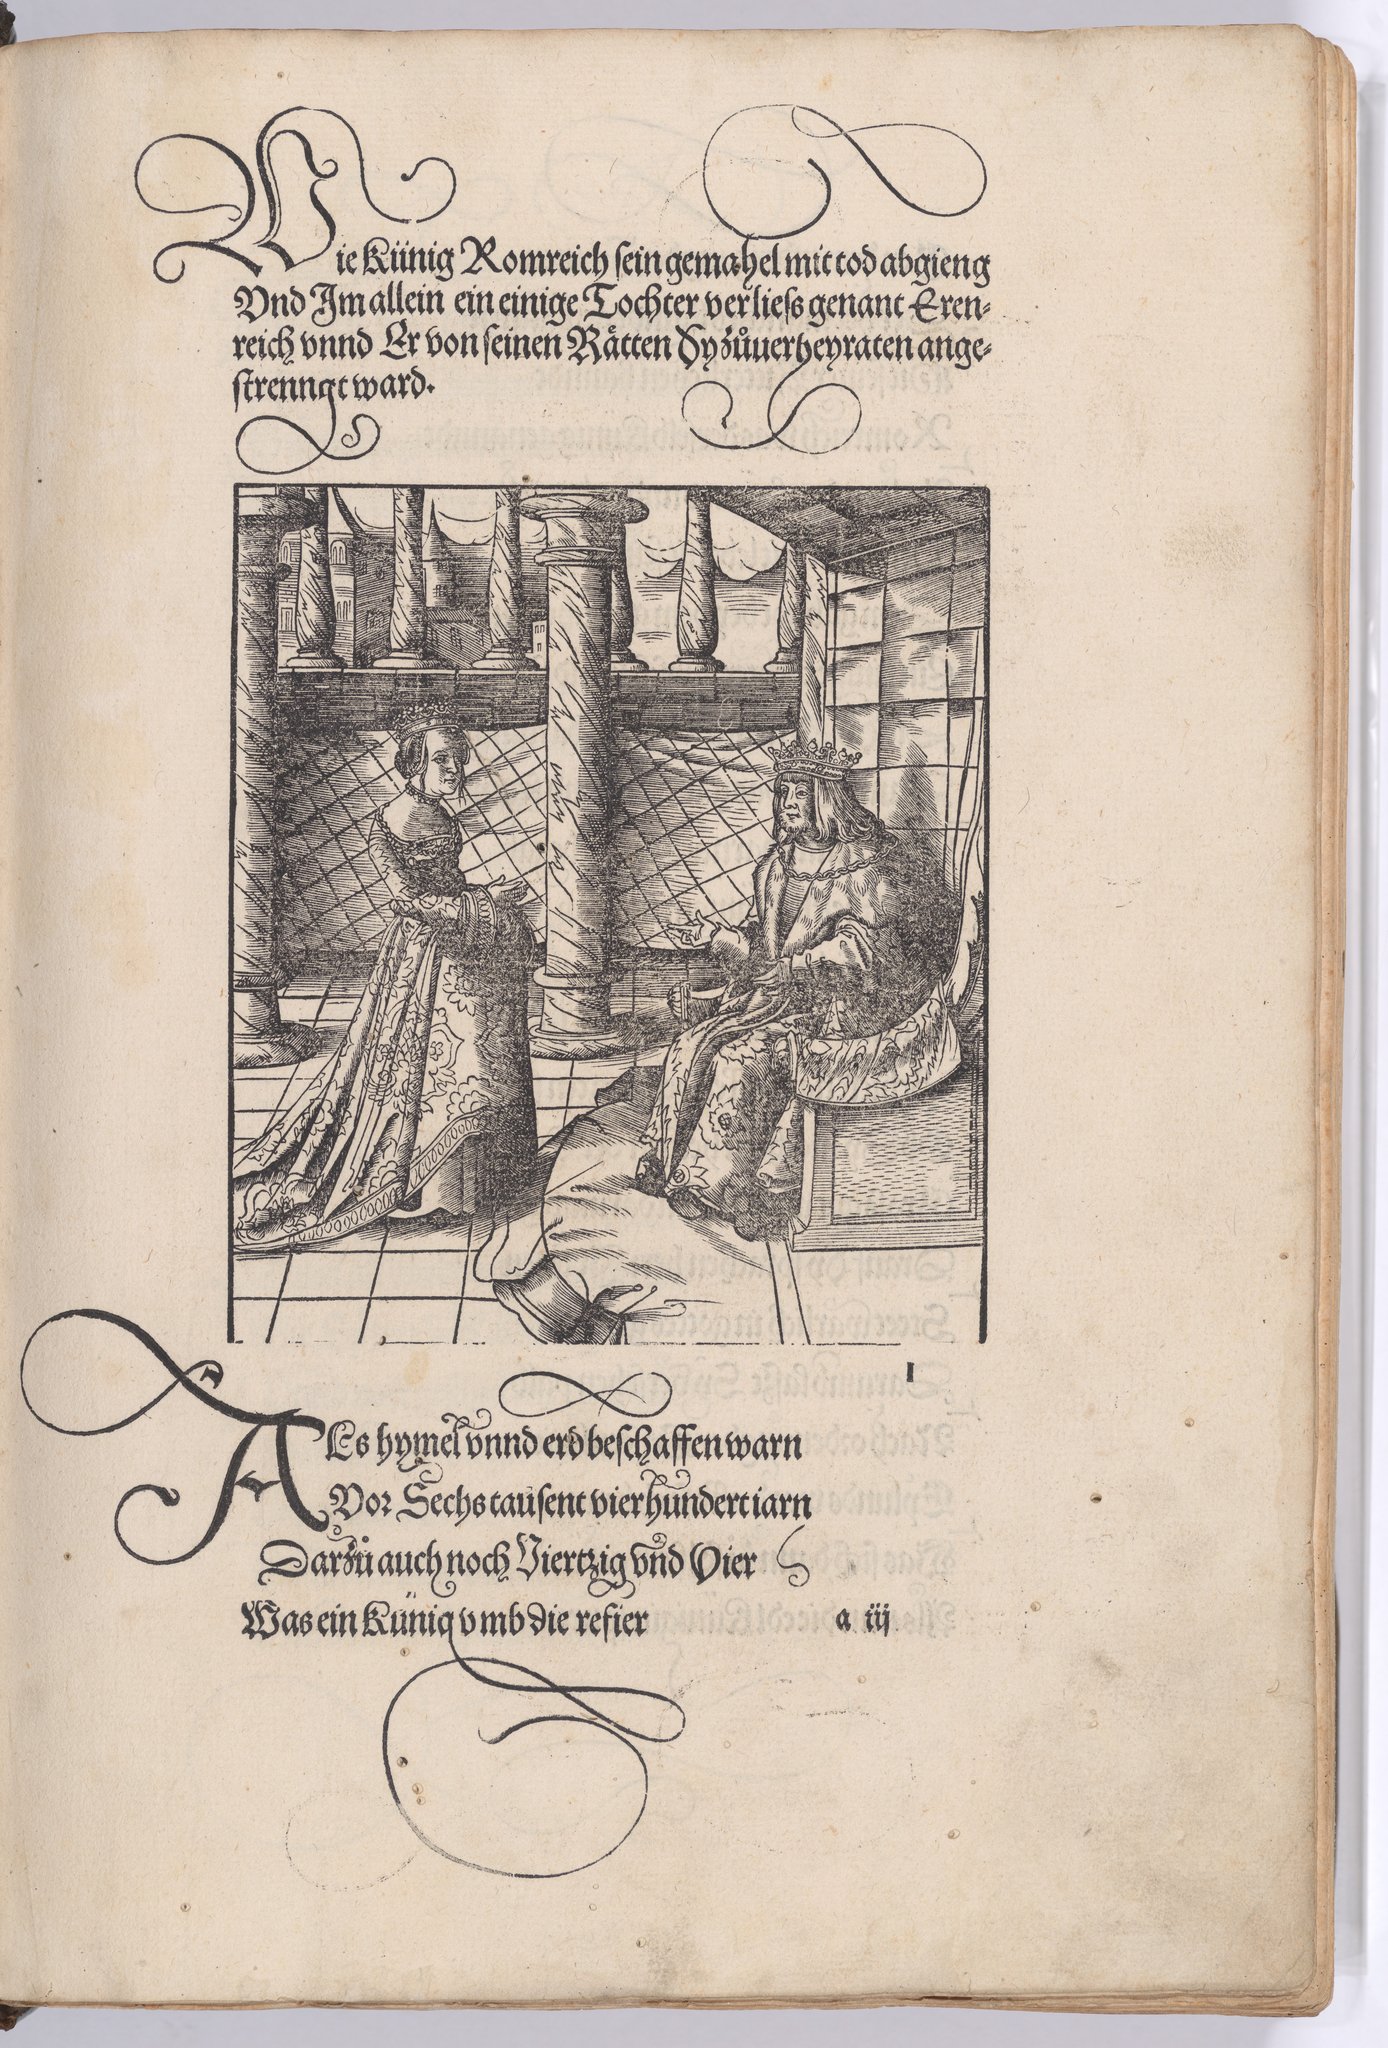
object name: book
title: Theuerdank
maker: melchior pfintzing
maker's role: author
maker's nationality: german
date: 1519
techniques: letterpress, woodcut